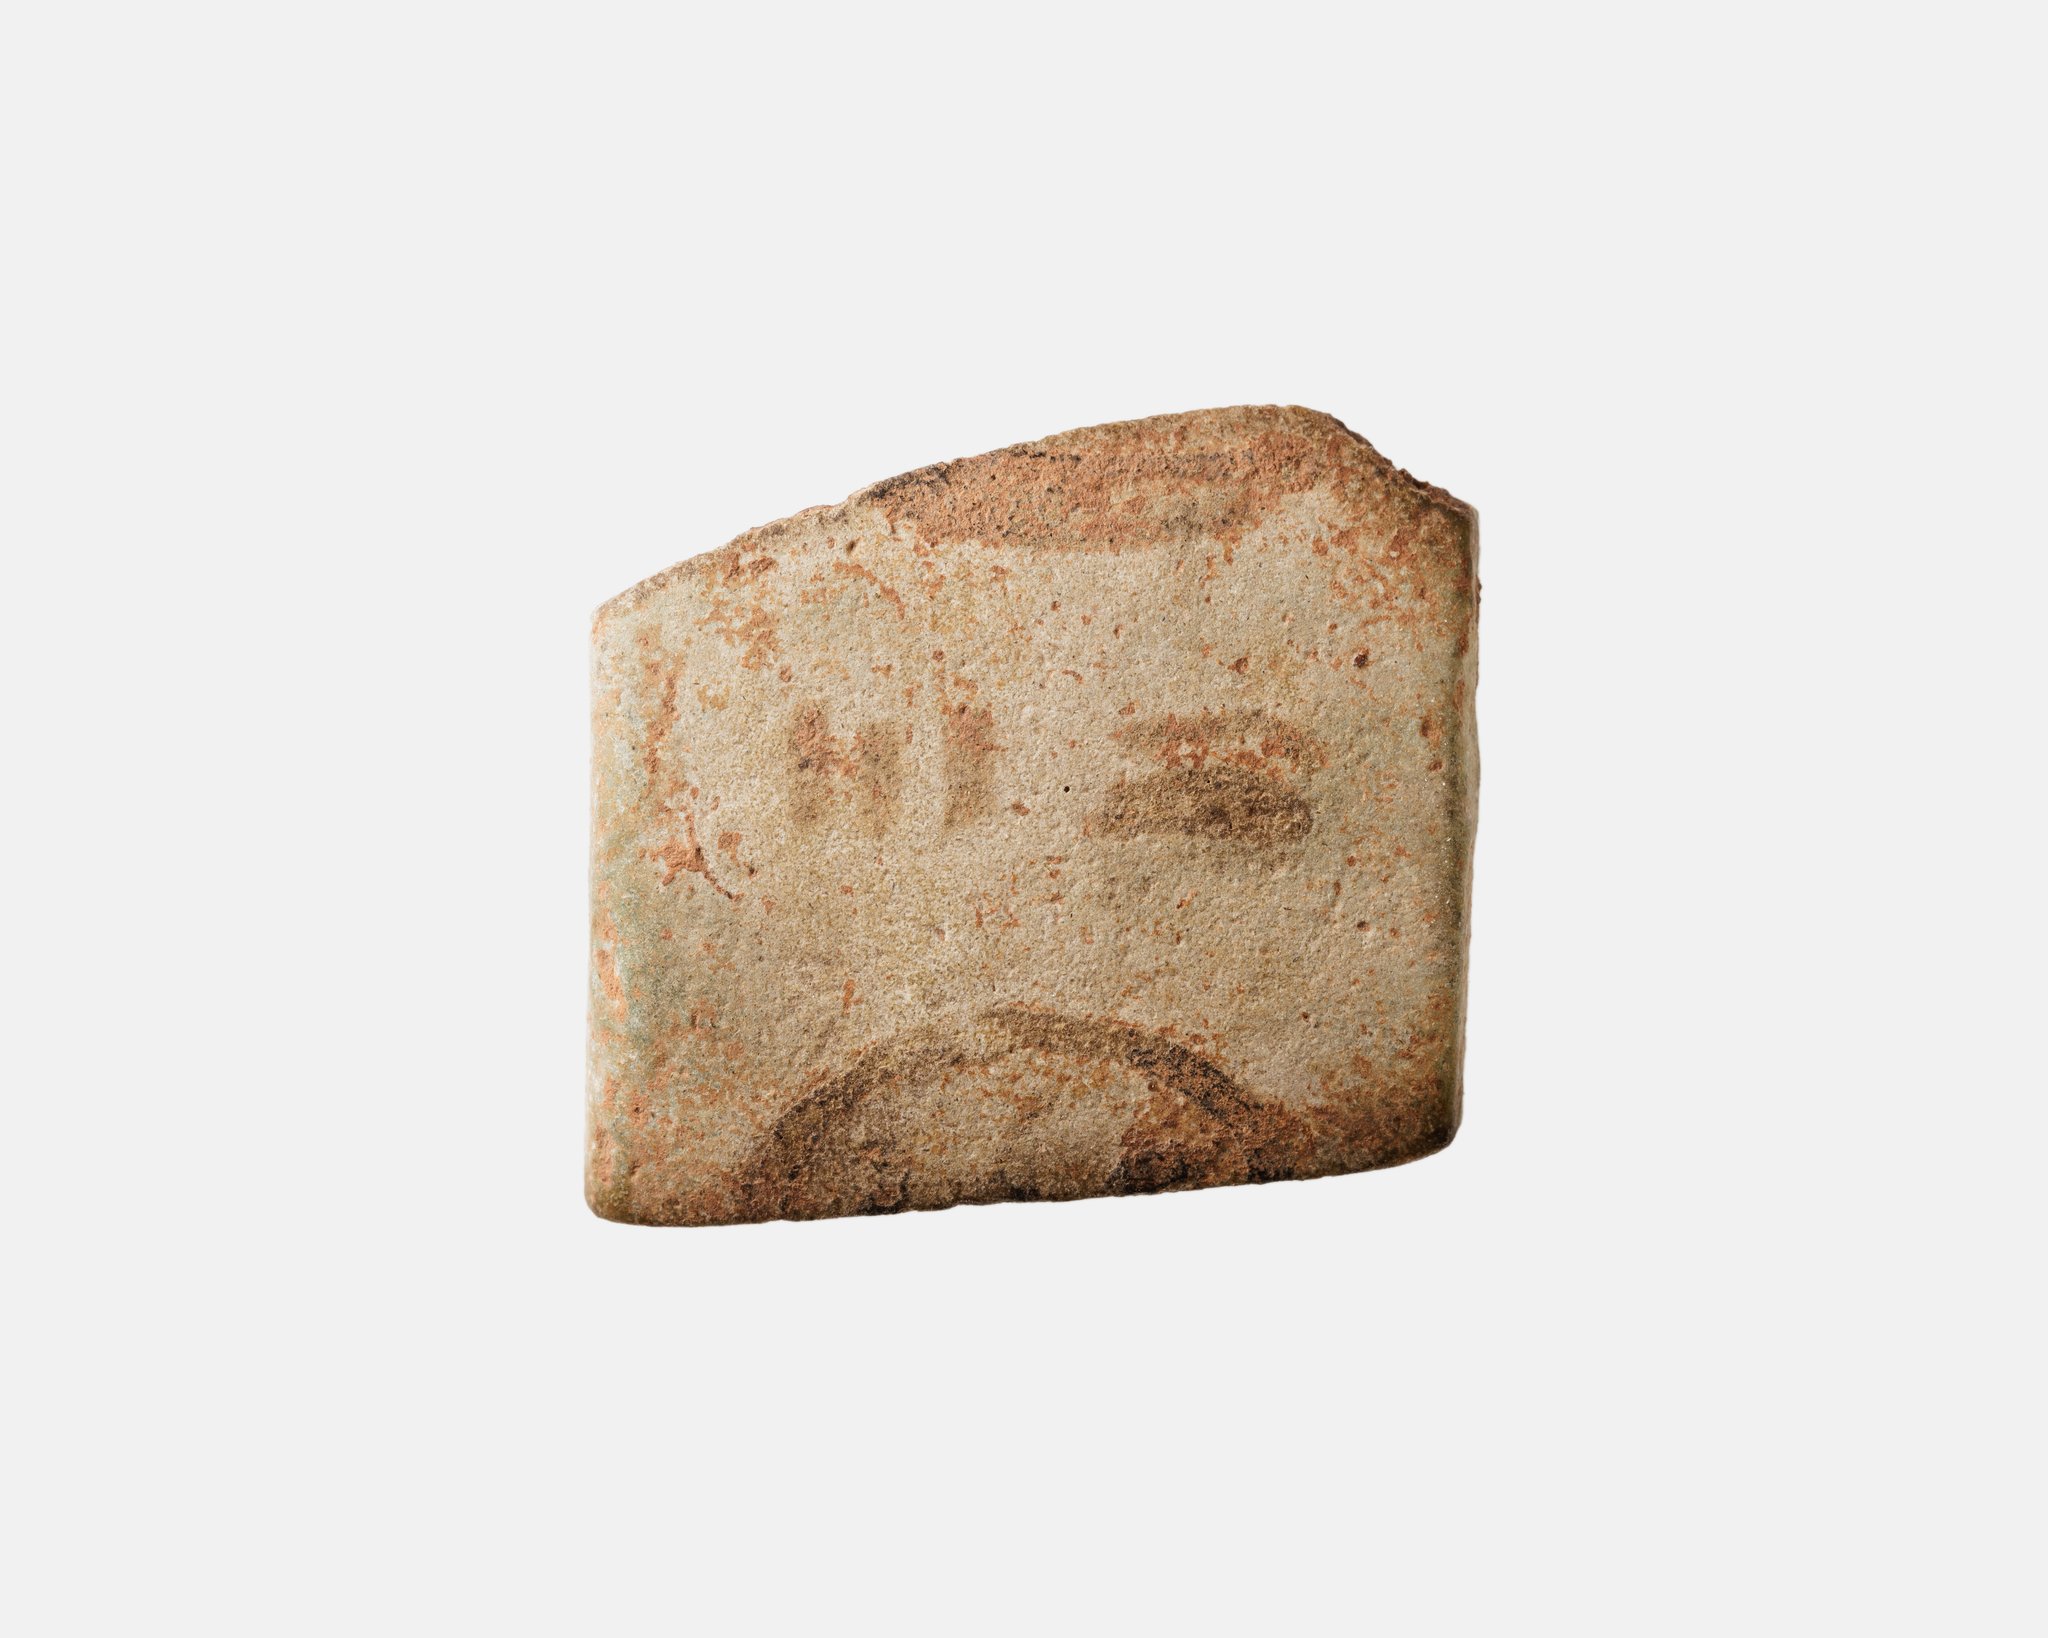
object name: votive bracelet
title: Fragment of a votive bracelet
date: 1295-1070 BCE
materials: faience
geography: egypt